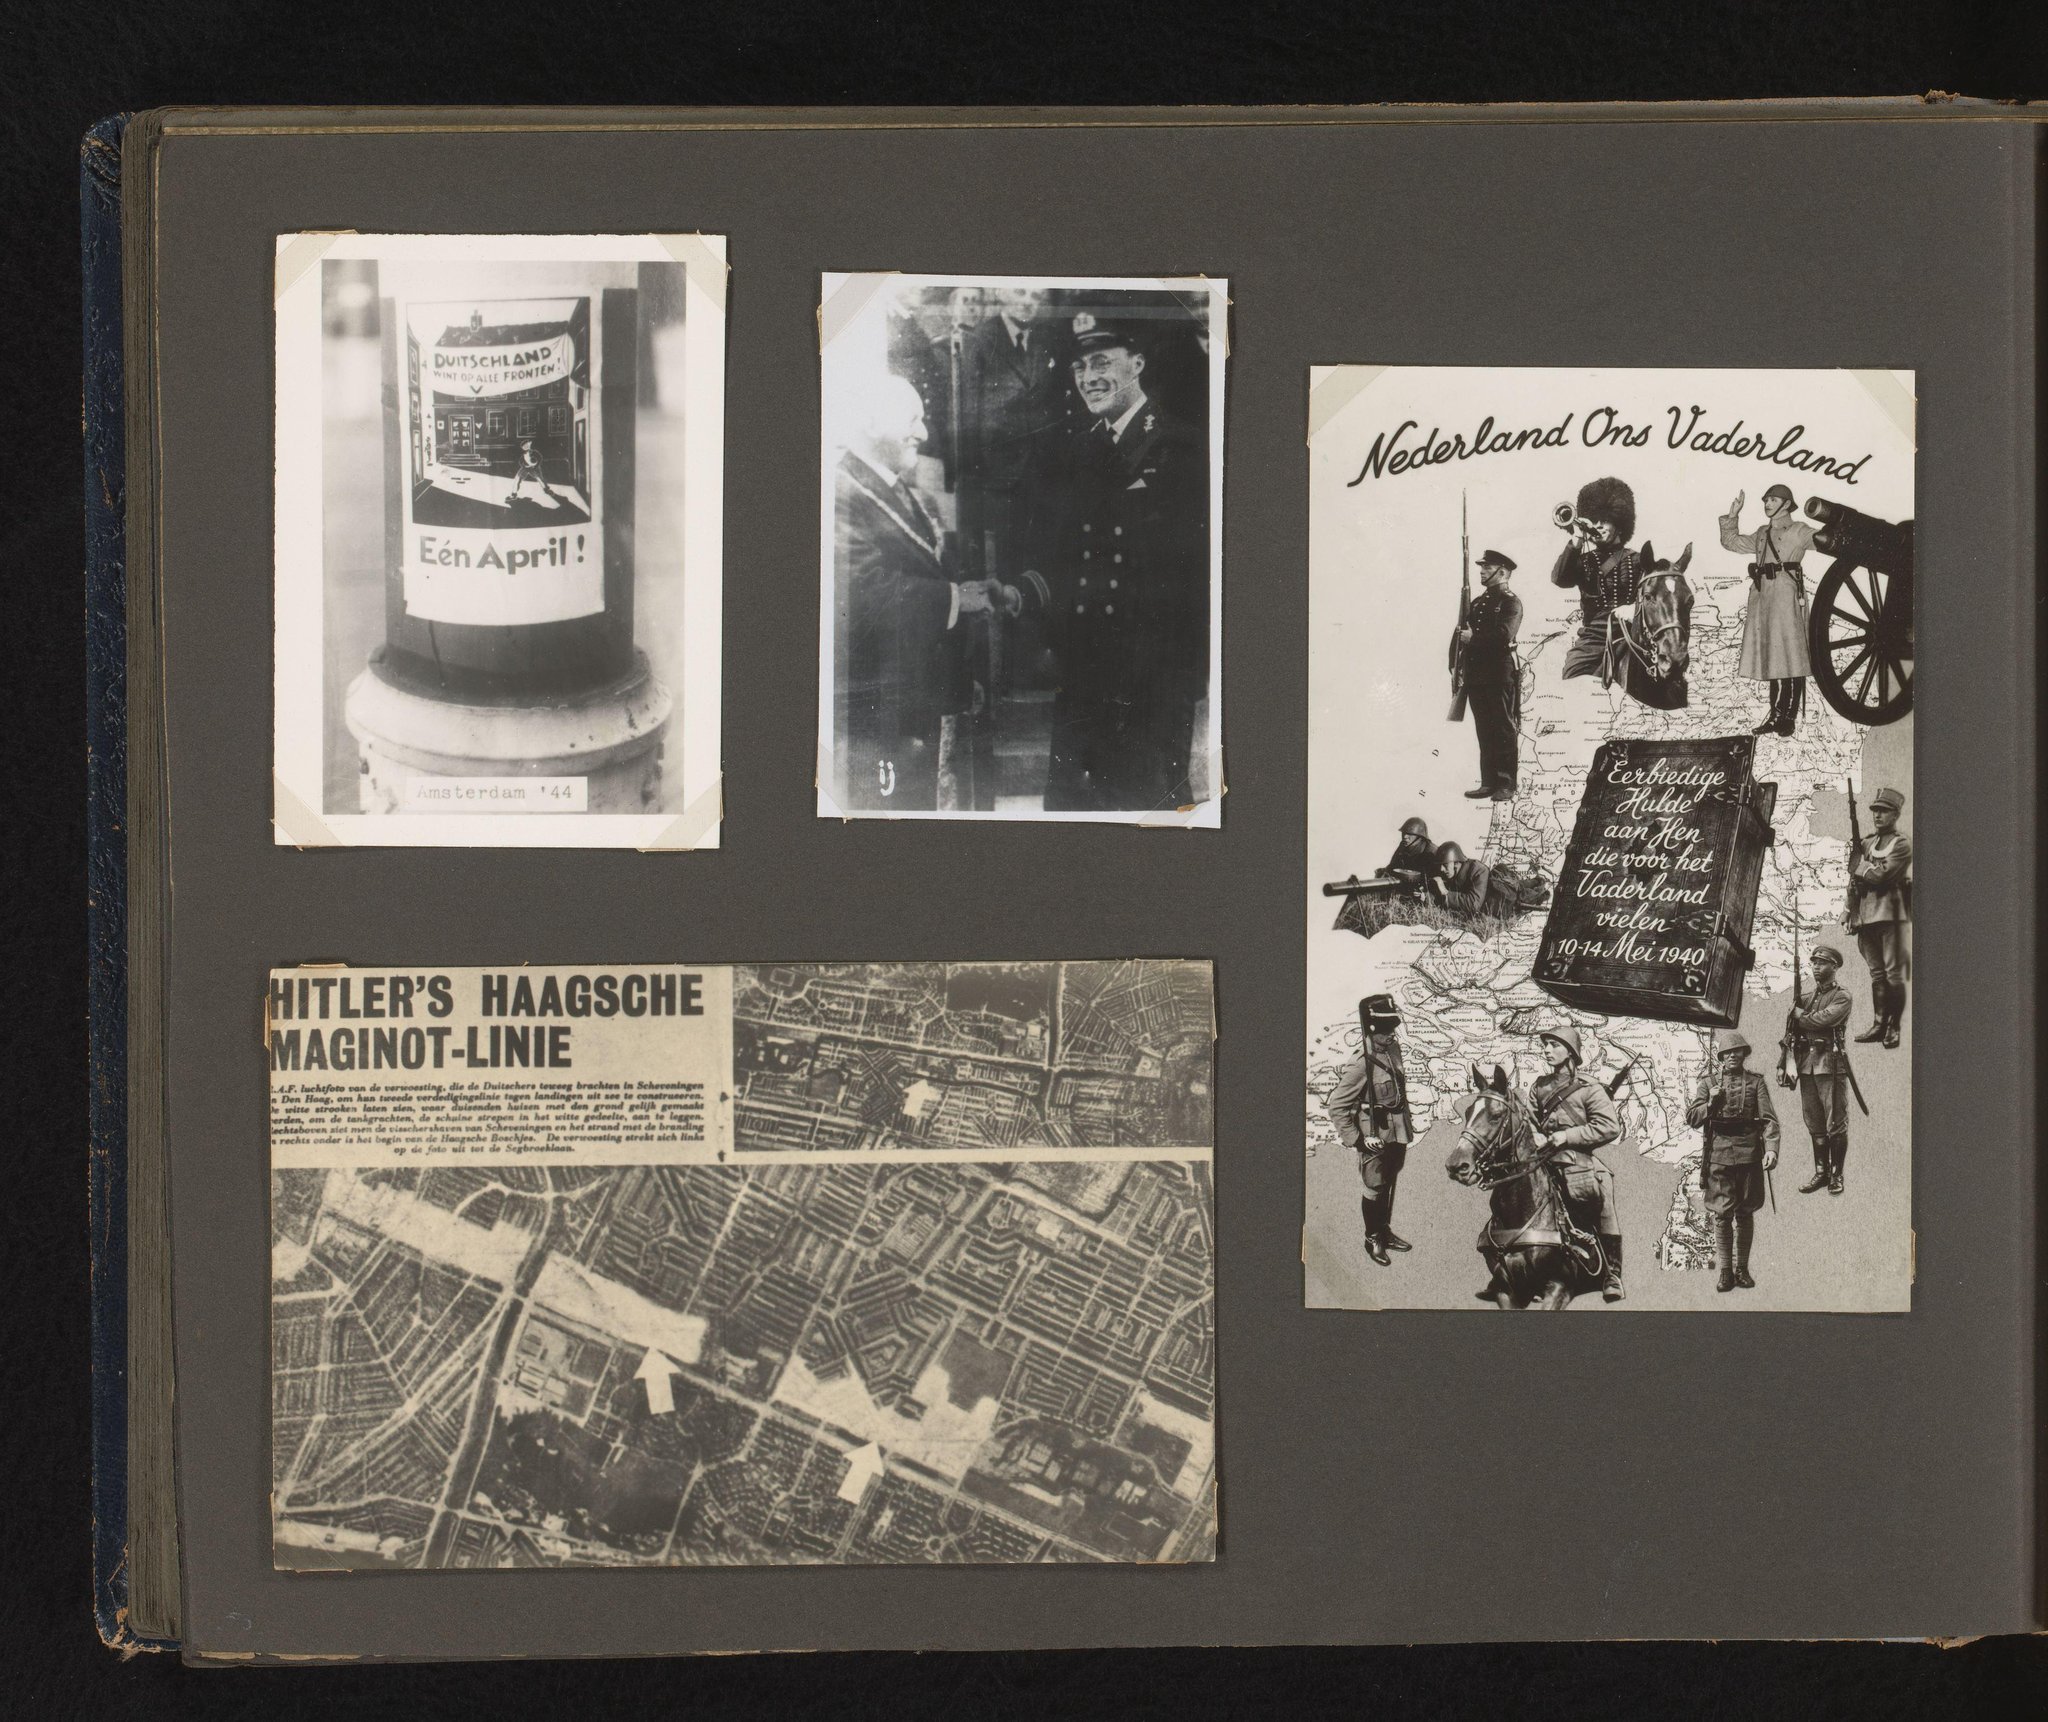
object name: photograph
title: Straataffiche en eerbetoon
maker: Anonymous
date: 1944-1945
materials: cardboard, photographic support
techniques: gelatin silver print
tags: utrecht, bernhard (prins der nederlanden), poster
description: Albumblad met vier foto's van een anti-Duitse affiche, een luchtfoto van Duitse afbraak in Scheveningen, Prins Bernhard en een eerbetoon aan de slachtoffers van de Duitse inval 10-14 mei 1940. Onderdeel van fotoalbum over het familieleven van de leden van het Koninklijk Huis tussen 1937-1945.